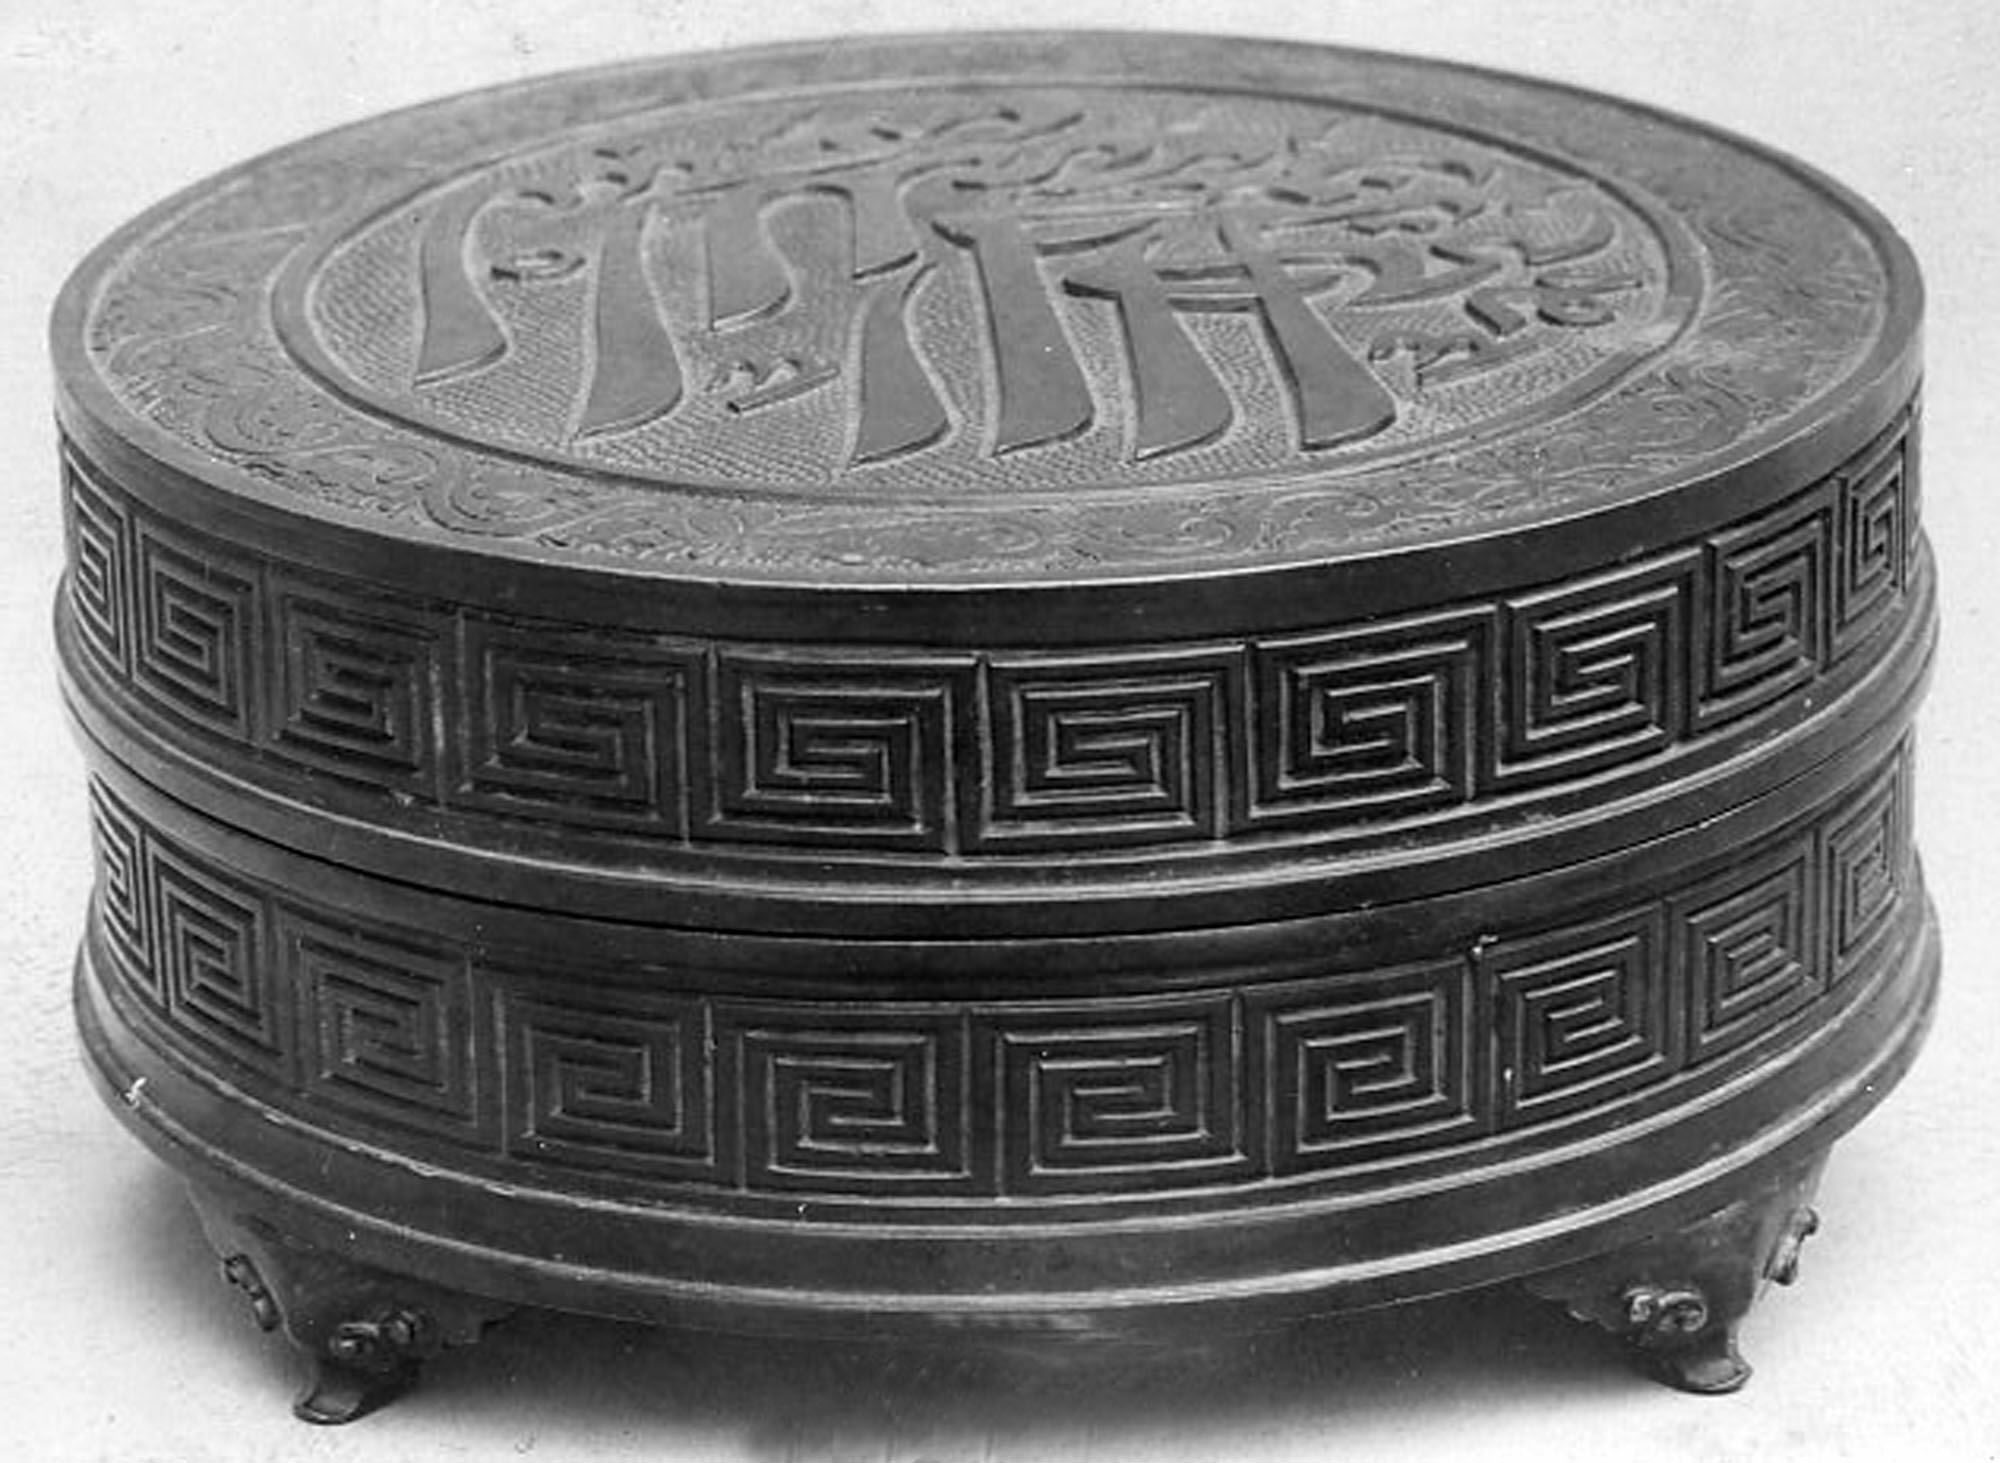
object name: covered box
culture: chinese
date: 1601-1700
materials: bronze